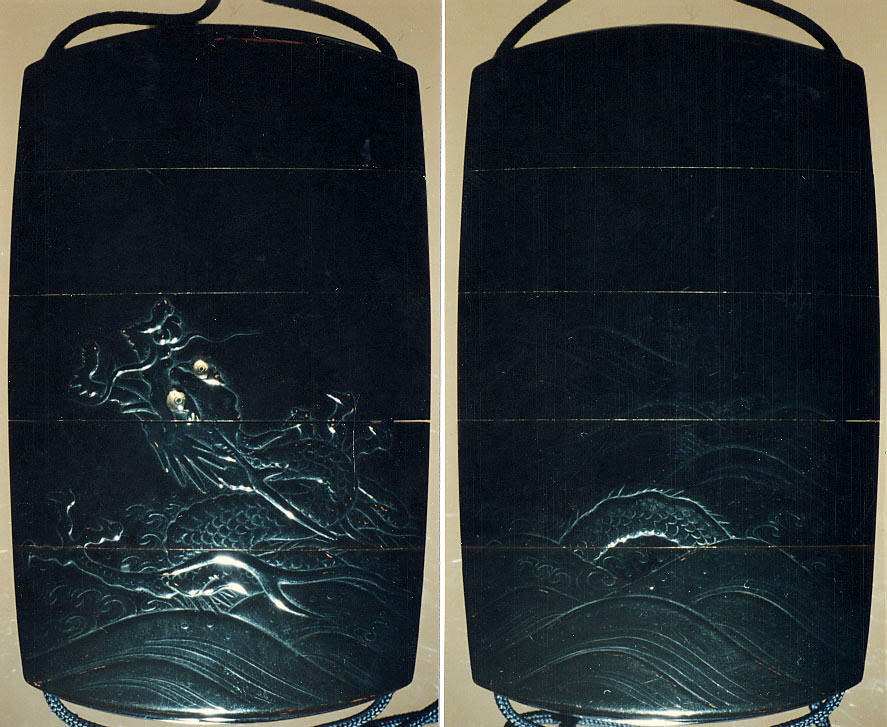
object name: inrō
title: Case (Inrō) with Design of Dragon Emerging from Waves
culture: japanese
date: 1701-1900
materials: lacquer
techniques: fundame, hiramakie, inlay, roiro, maki-e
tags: dragons,waves